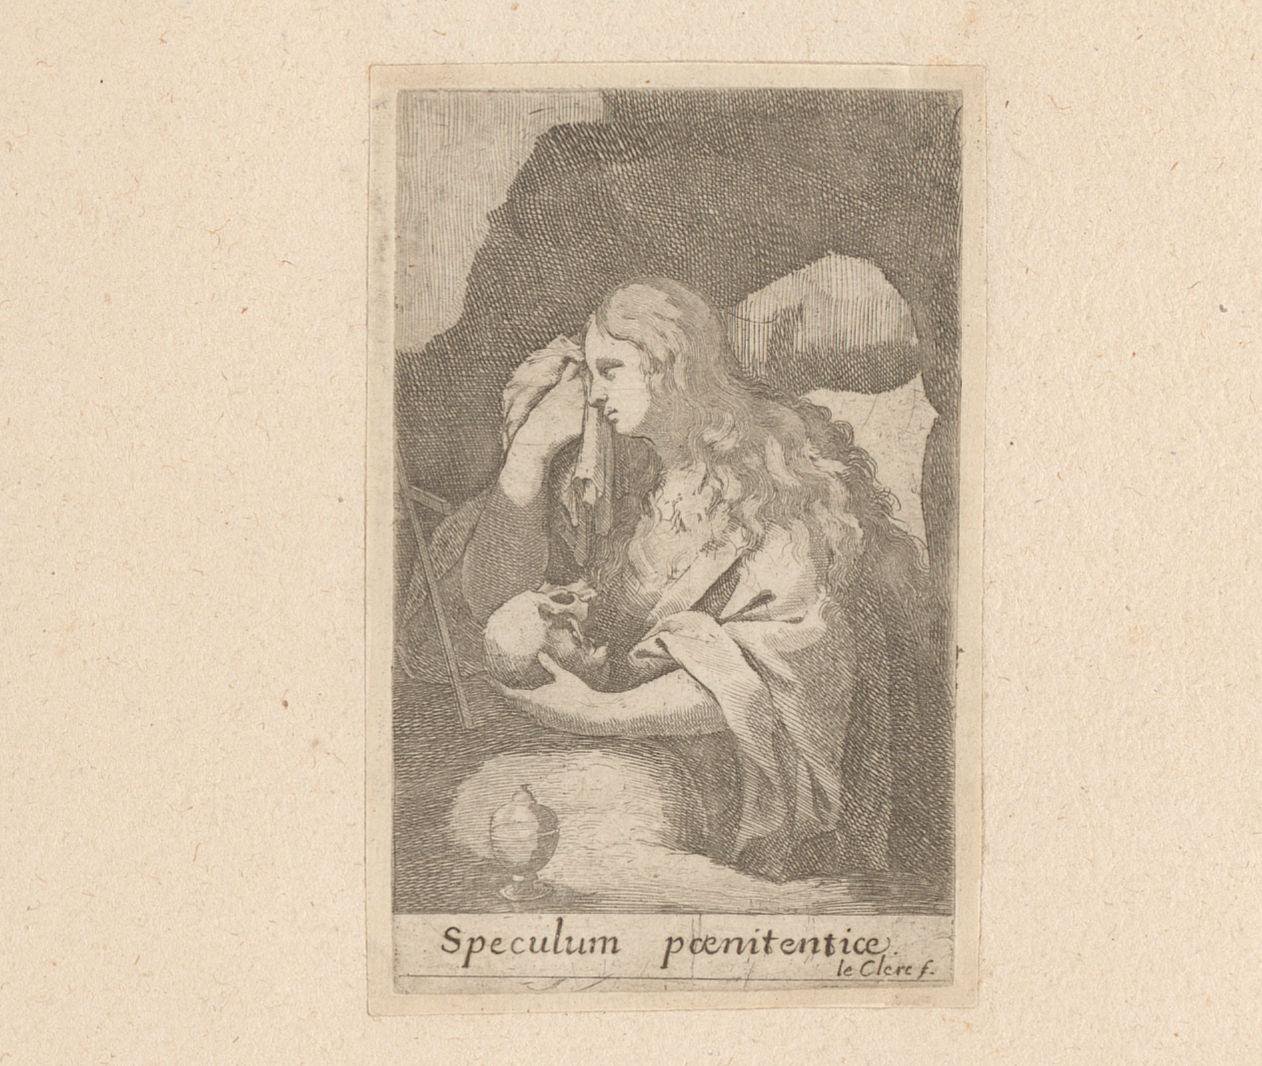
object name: print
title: Speculum paenitentice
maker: sébastien leclerc (i)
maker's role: print maker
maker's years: 1637-1714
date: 1647-1714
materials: paper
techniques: etching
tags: the penitent harlot mary magdalene; possible attributes: book (or scroll), crown, crown of thorns, crucifix, jar of ointment, mirror, musical instrument, palm-branch, rosary, scourge